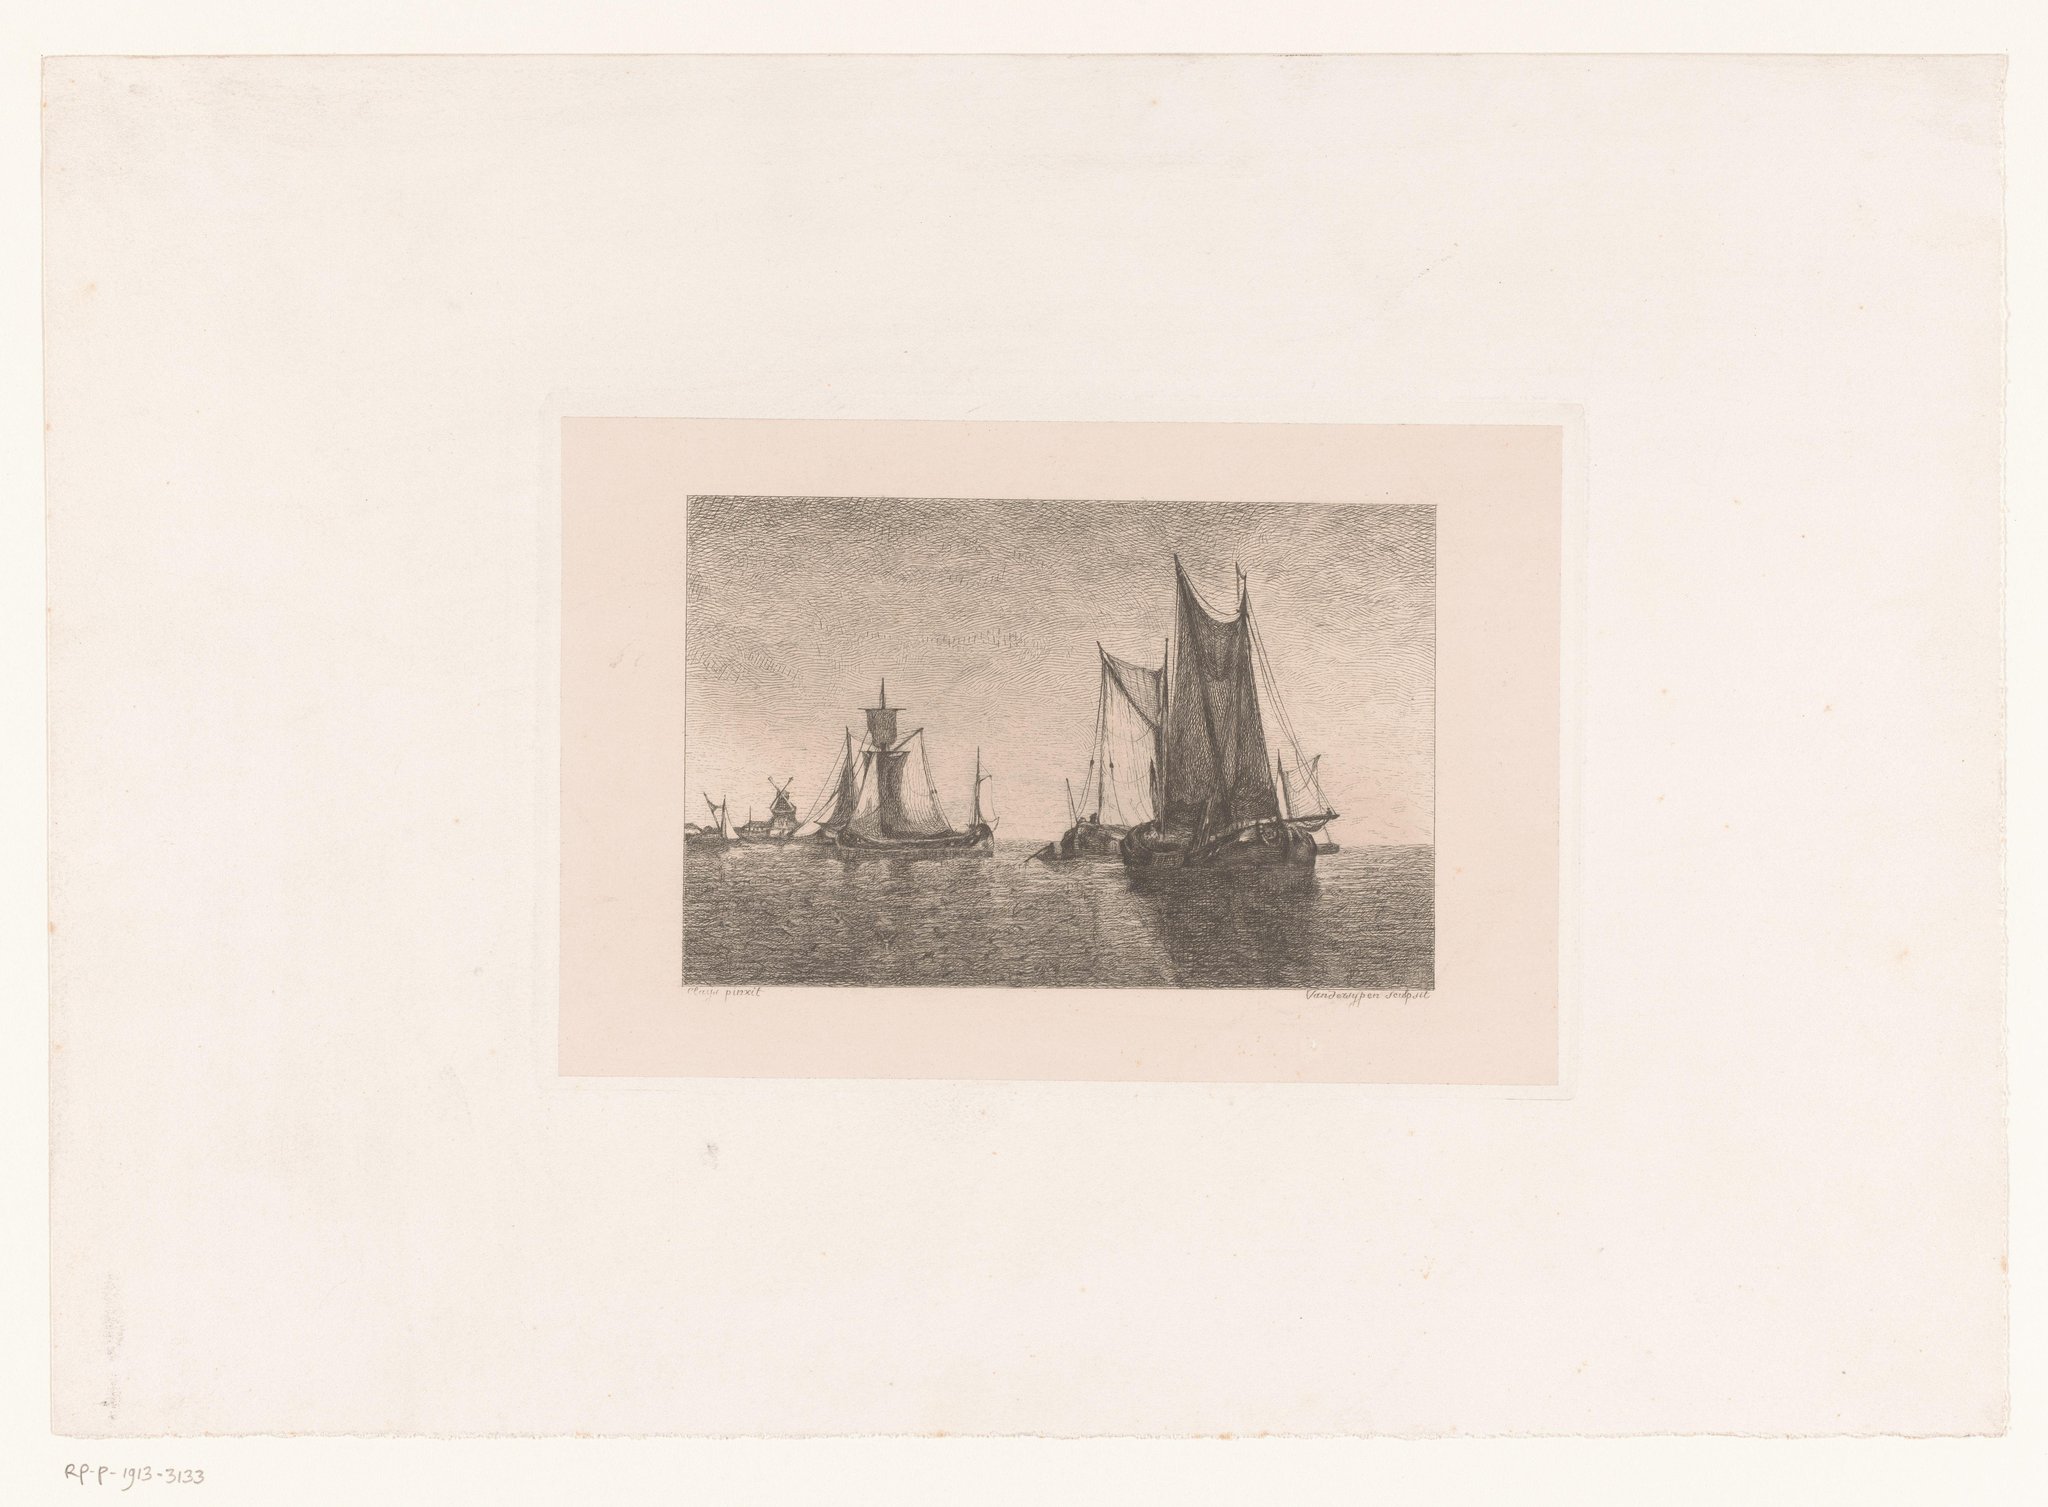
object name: print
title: Zeilboten op het water met molen op de achtergrond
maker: paul jean clays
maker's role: print maker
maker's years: 1819-1900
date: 1825-1899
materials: paper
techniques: etching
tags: sailing-ship, sailing-boat, windmill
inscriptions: collector's mark: Lugt 2228